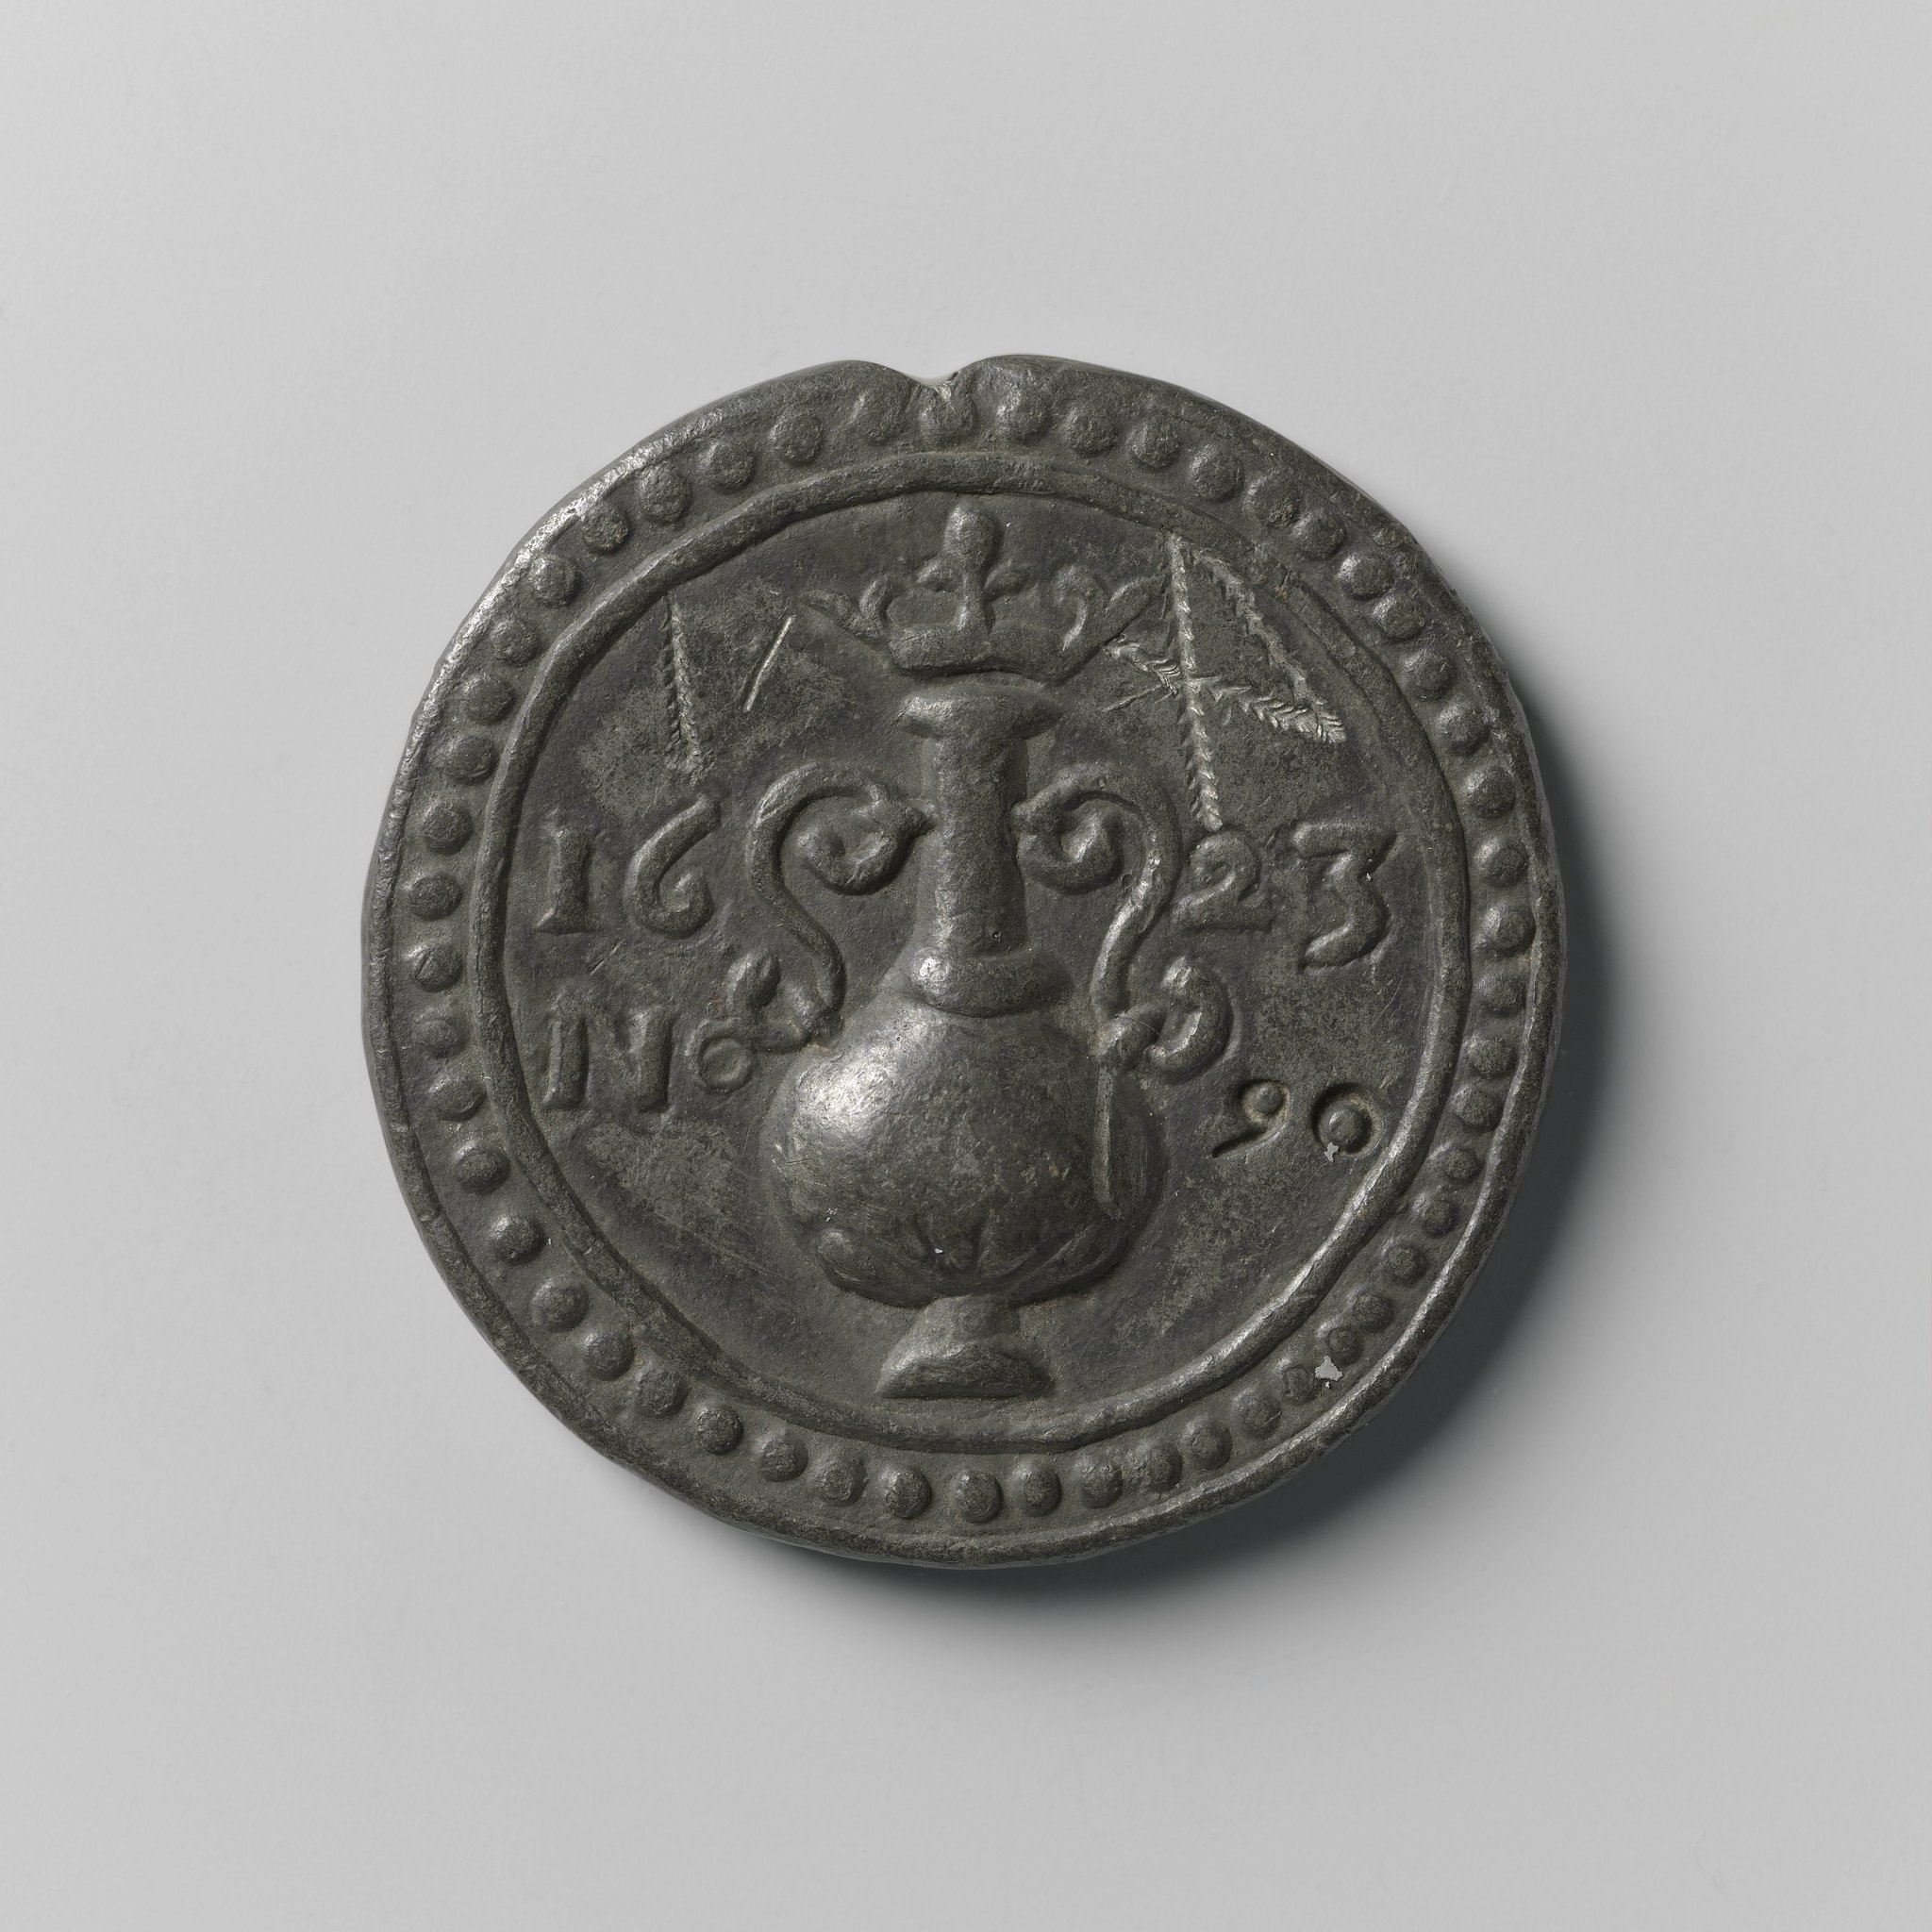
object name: medal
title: Scheepmakersgilde van Vlissingen, gildepenning met no. 1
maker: Anonymous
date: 1623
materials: lead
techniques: casting, engraving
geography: flushing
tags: flushing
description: Loden penning. Voorzijde: schip in aanbouw; daarboven: zaag en twee gekruiste bijlen binnen omschrift. Keerzijde: gekroonde fles tussen jaartal en opschrift No. 1 [?] binnen omschrift